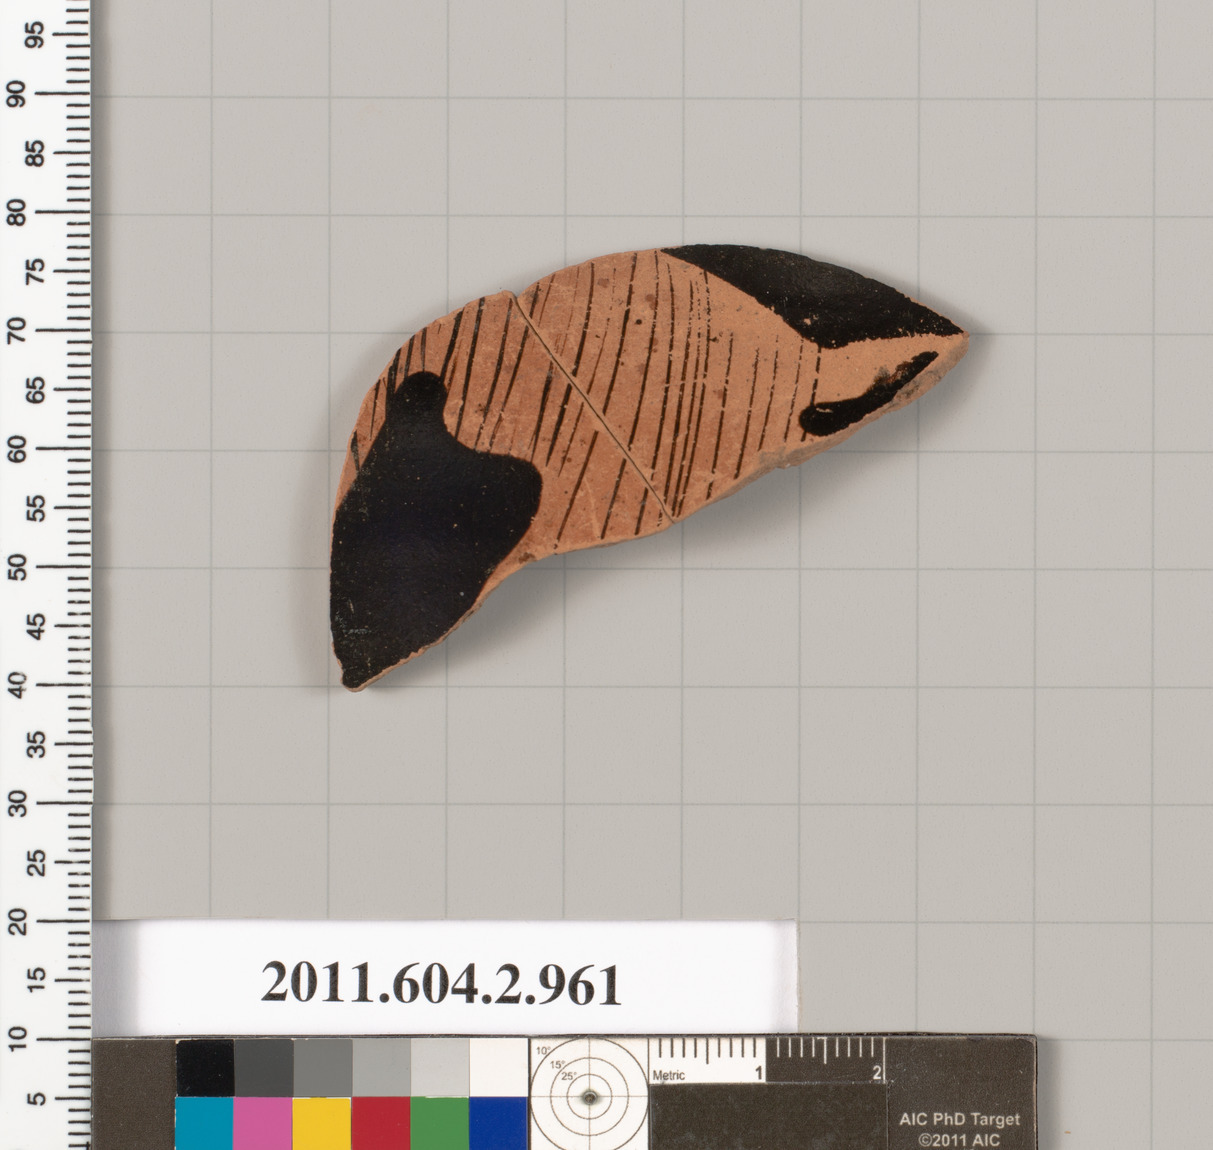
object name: oinochoe fragment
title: Terracotta fragment of an oinochoe (jug)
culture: greek, attic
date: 450-426 BCE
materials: terracotta